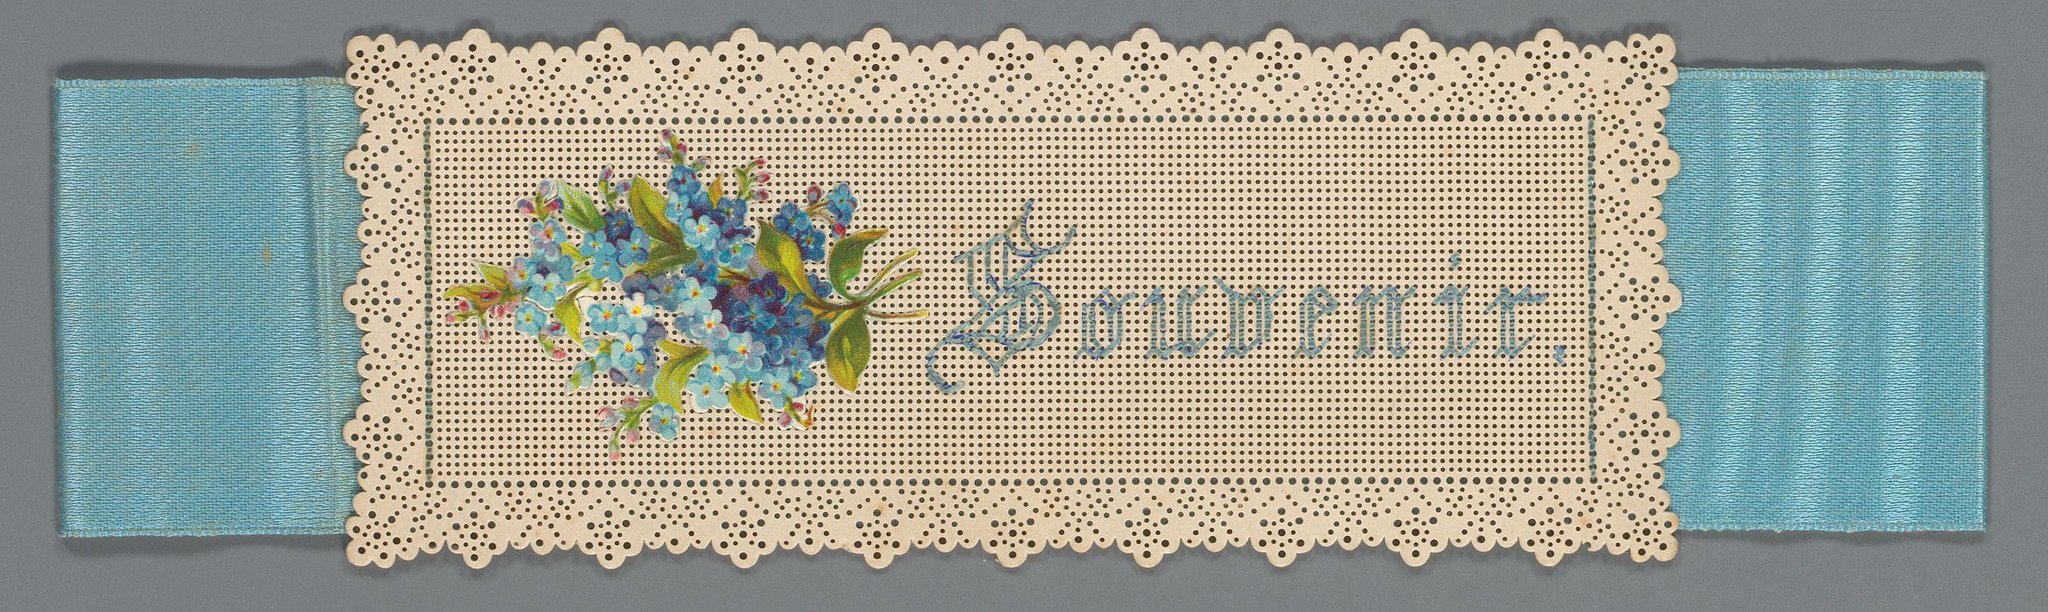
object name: embroidery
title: Boekenlegger met borduurwerk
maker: Anonymous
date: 1880-1980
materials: cardboard, paper, silk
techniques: embroidered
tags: book-marker, (other forms of) needlework, e.g.: crocheting, knitting, embroidering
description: Boekenlegger met borduurwerk 'Souvenir' op geschubd karton met gestanste gaatjes, met poesieplaatje van vergeet-mij-nietjes geplakt op strook blauwe zijde.